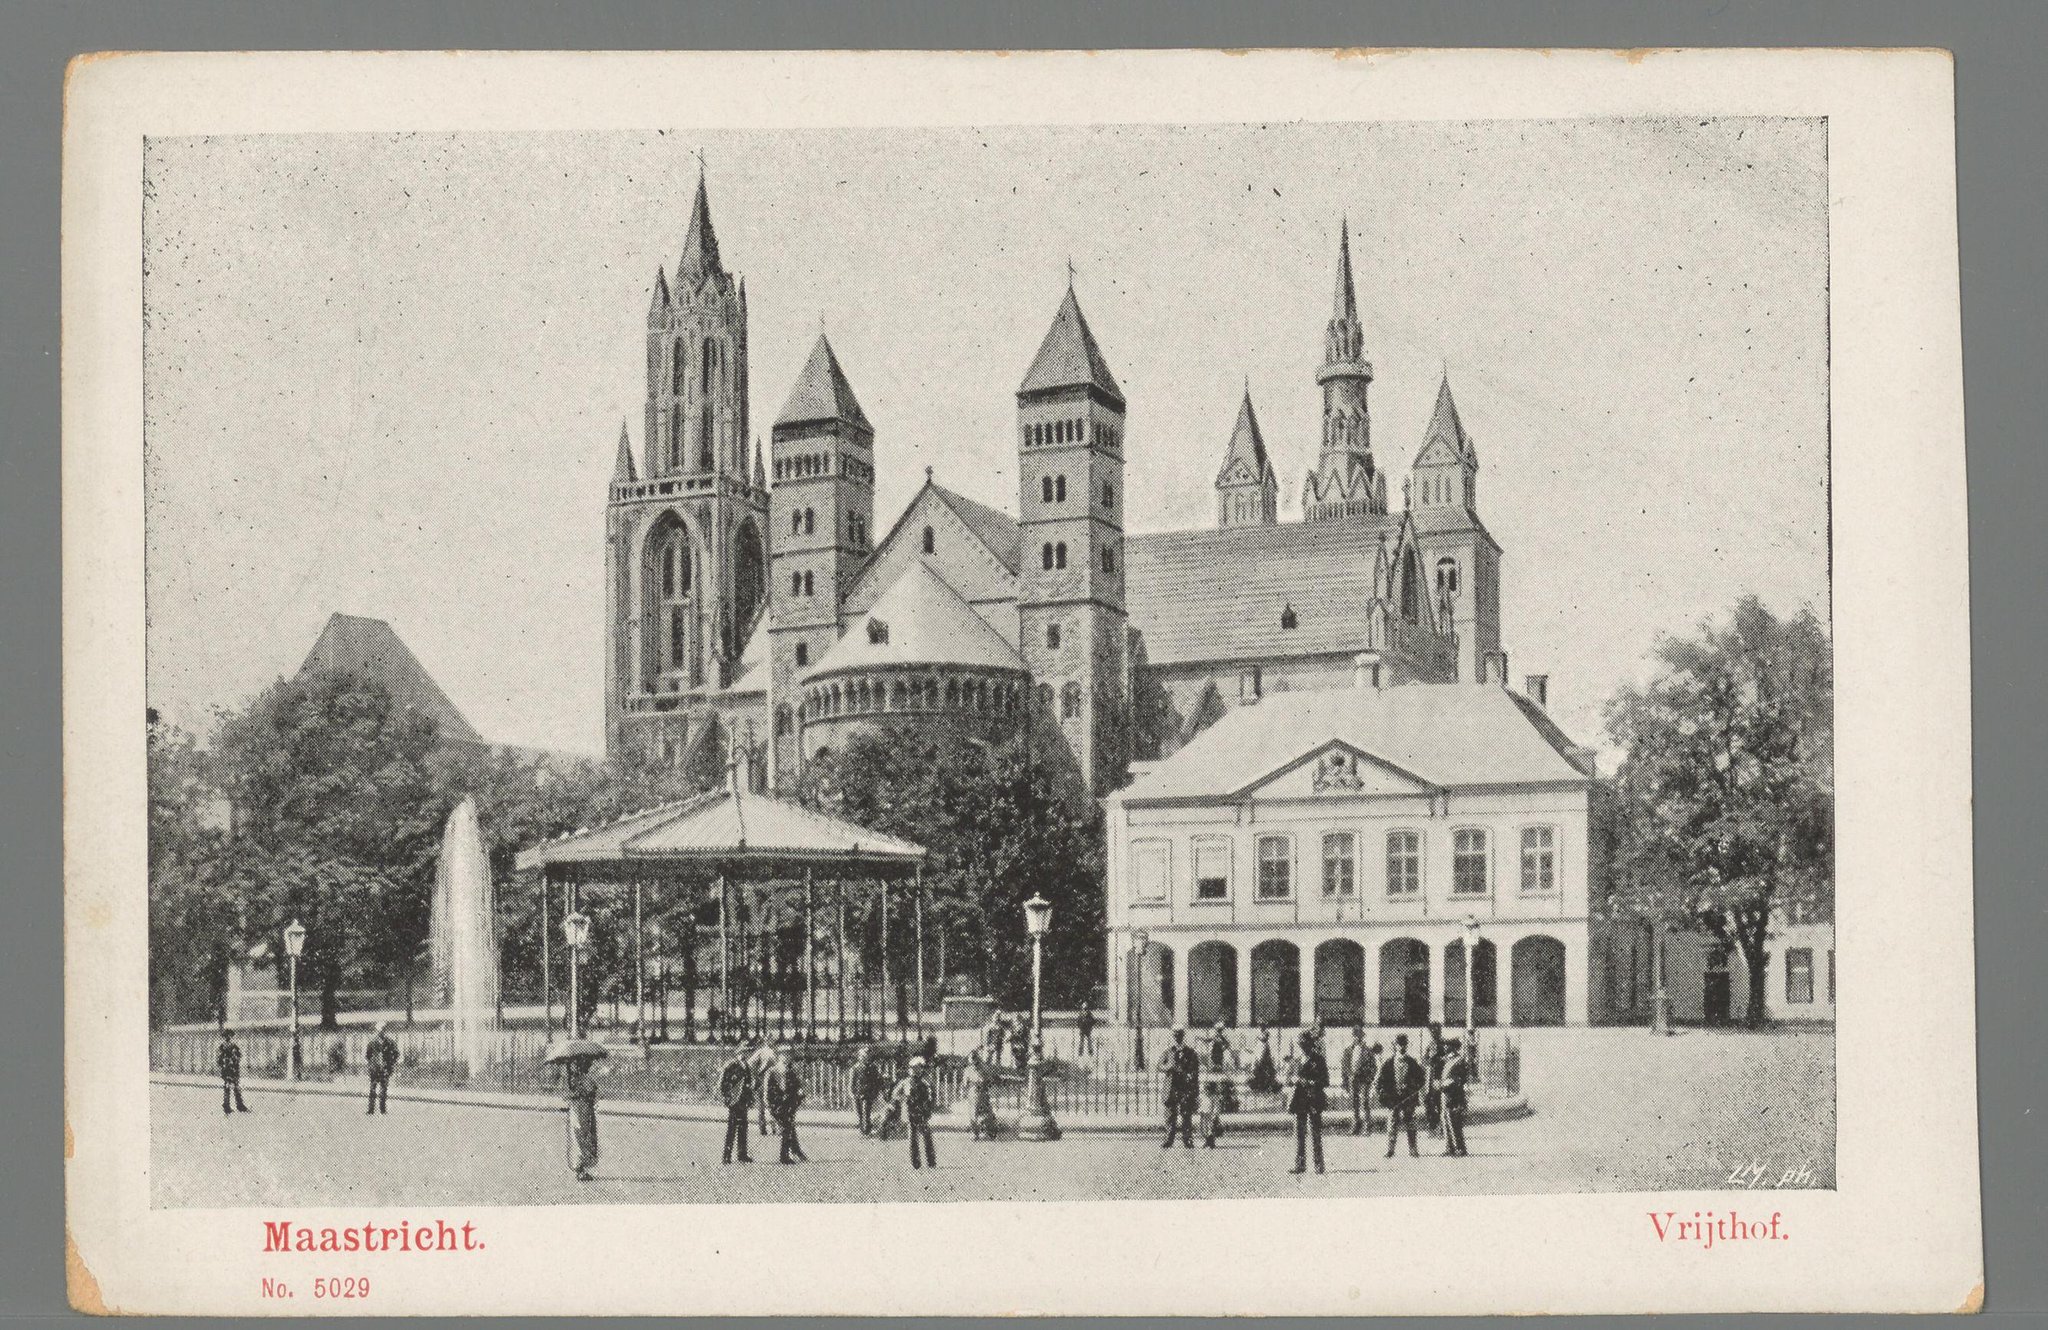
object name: photomechanical print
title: Maastricht. Vrijthof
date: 1892-1905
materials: cardboard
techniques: autotype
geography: maastricht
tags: square, place, circus, etc., church (exterior)